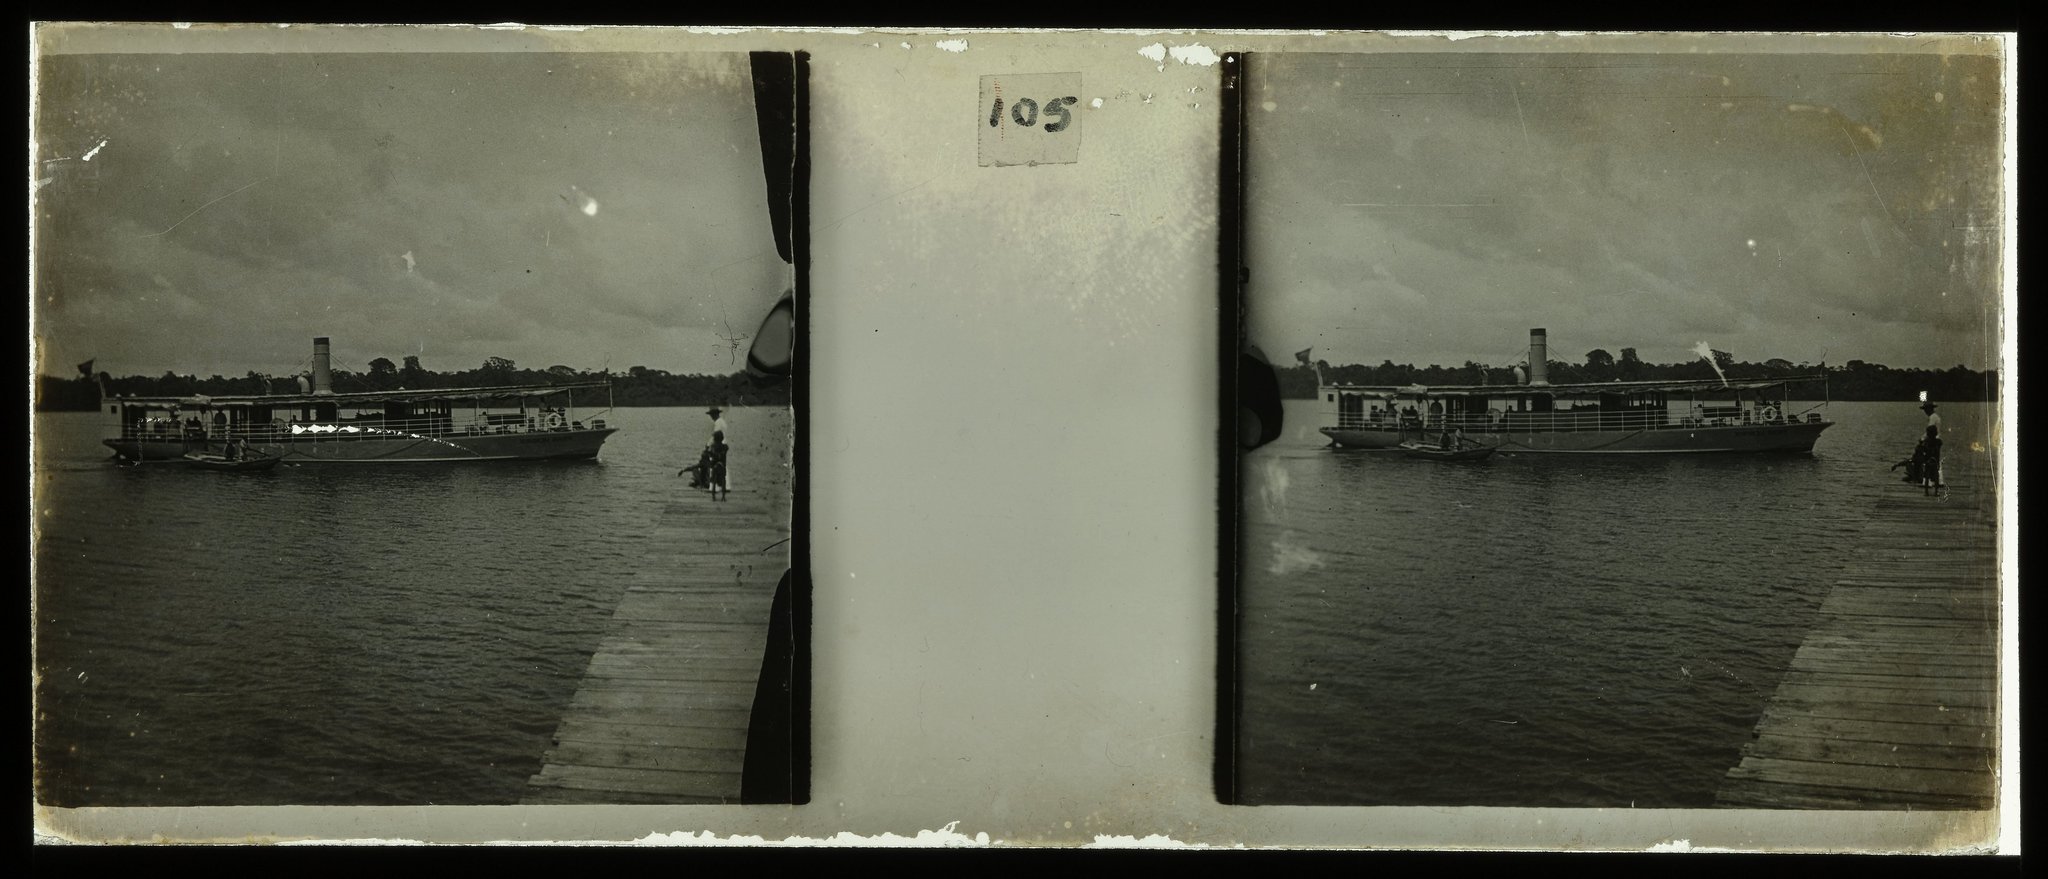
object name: stereograph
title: Rivierboot Prins Hendrik bij de steiger van plantage Accaribo.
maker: theodoor brouwers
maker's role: amateurfotograaf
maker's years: 1874-1932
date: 1913-1930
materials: glass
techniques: photography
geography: suriname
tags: amsterdam, theodoor brouwers, plantation, suriname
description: In de periode 1911-1932 woonde op plantage Accaribo in Suriname de familie Brouwers van wie de foto's afkomstig zijn. Rond 1910 vond Theodoor Brouwers werk op plantage Accaribo. In 1929 werd hij eigenaar van de plantage. Op Accaribo werden in zijn tijd bananen geproduceerd en wat koffie.